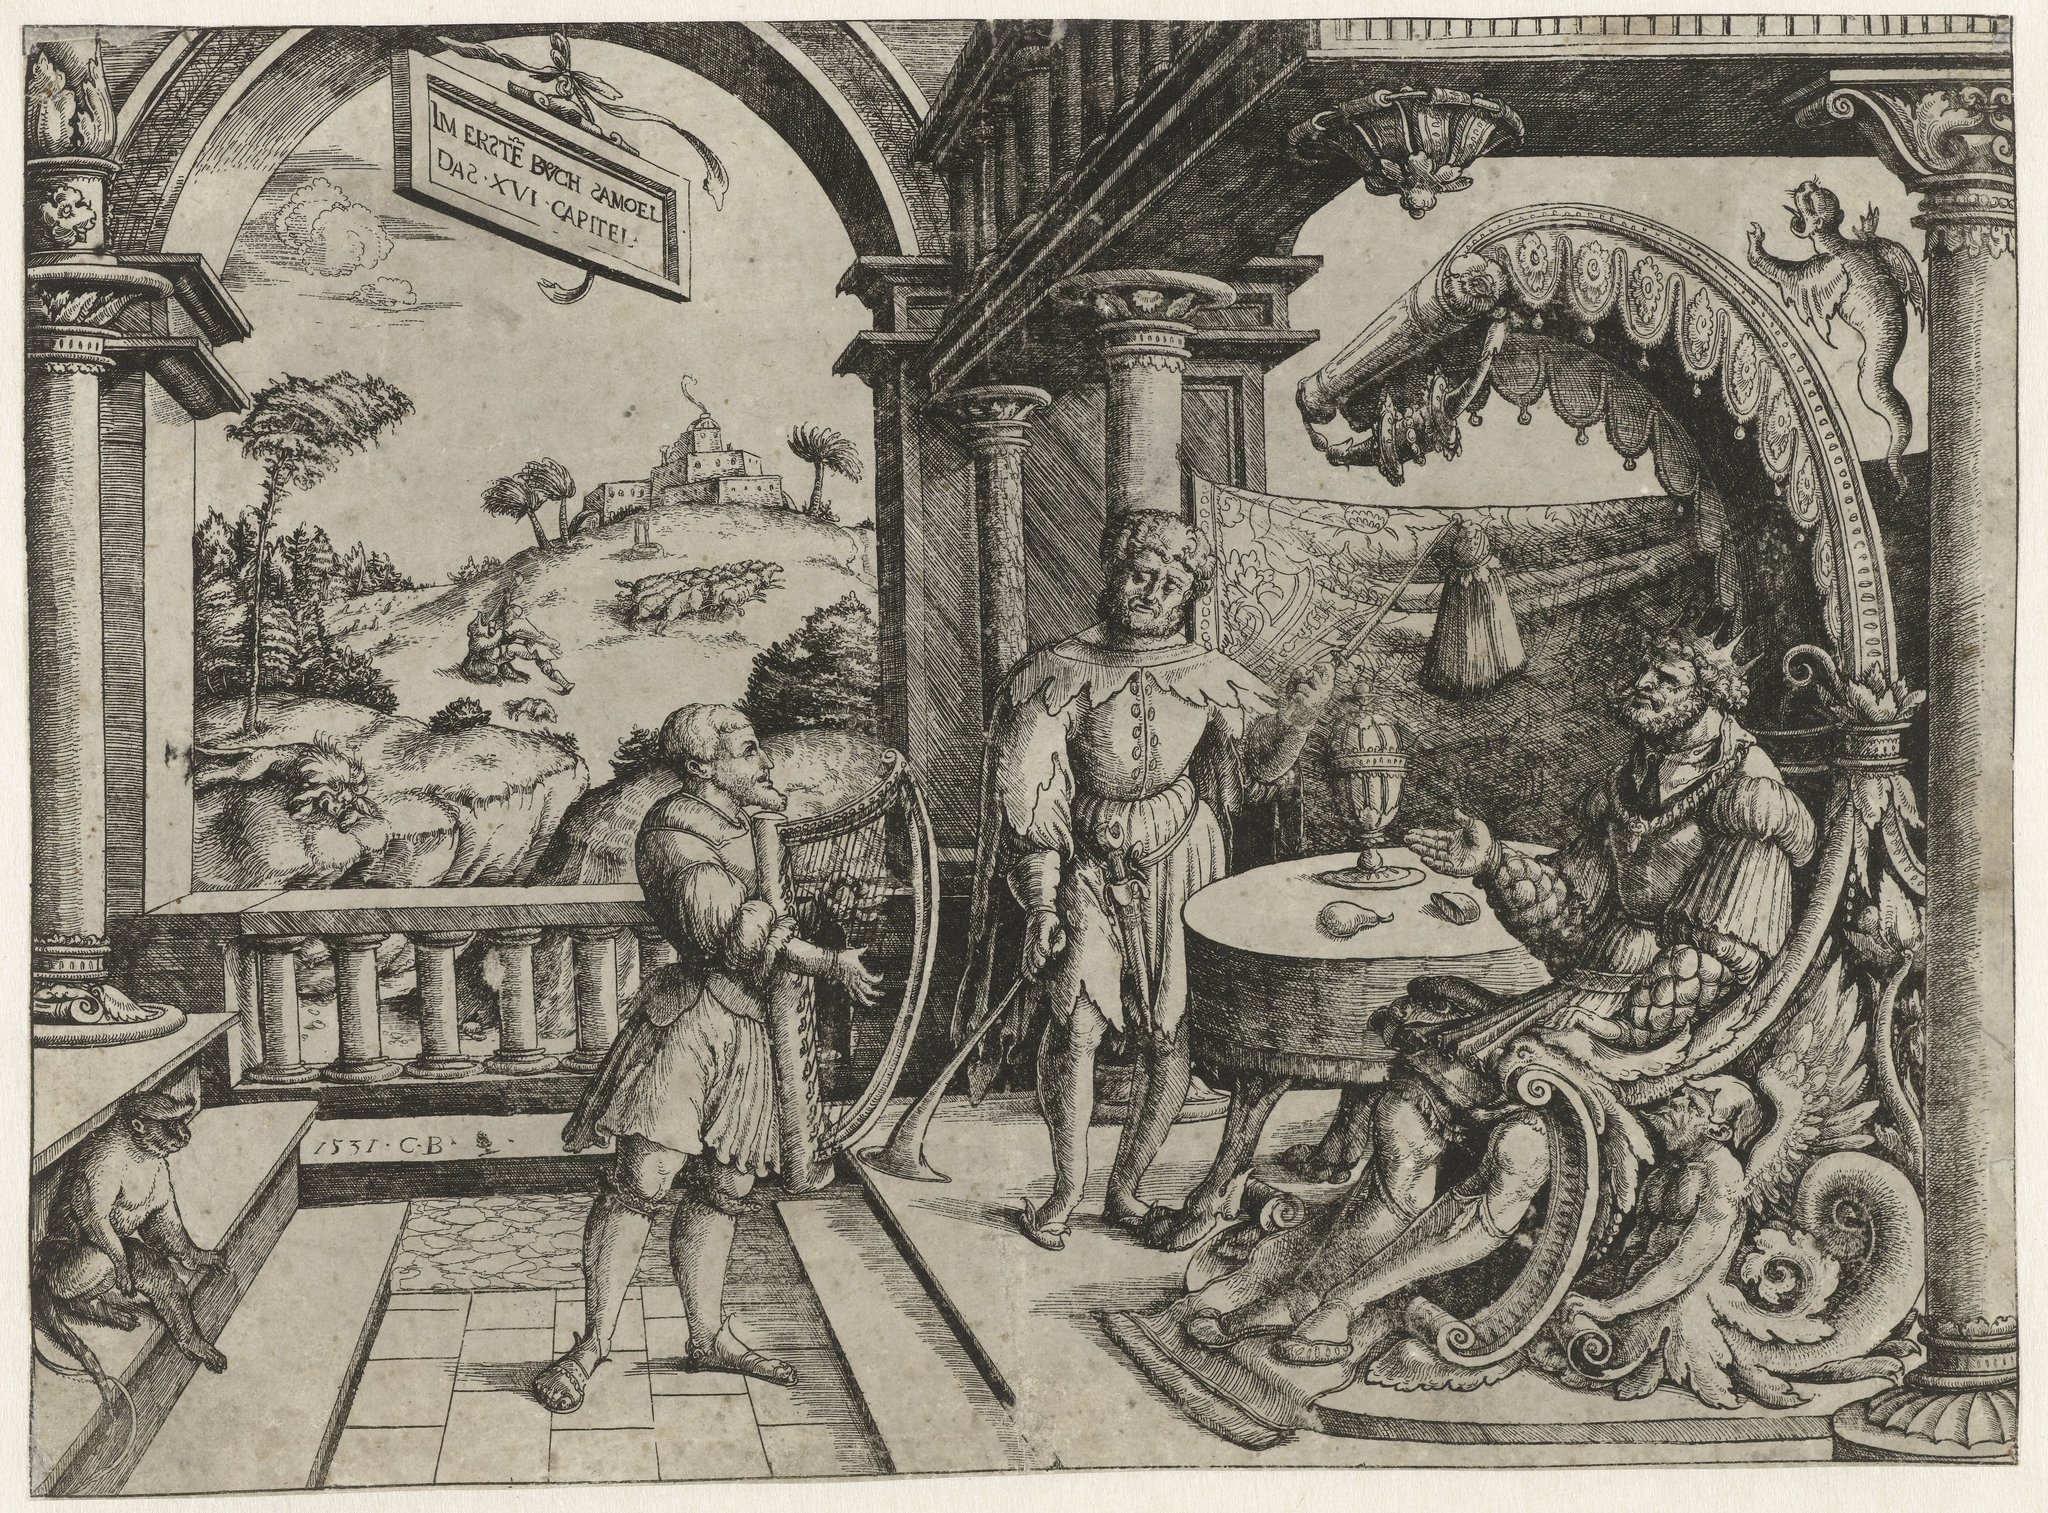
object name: print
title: David speelt harp voor Saul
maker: monogrammist cb met boom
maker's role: print maker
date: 1531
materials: paper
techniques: etching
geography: germany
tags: david as shepherd, david playing his harp before saul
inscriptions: collector's mark: Lugt 2228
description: Saul zittend op een troon in zijn paleis. Voor hem staat David die speelt op zijn harp, waardoor de kwade geest, in de vorm van een fantasie wezen, van Saul wegvliegt (1 Samuel 16:23). In het landschap op de achtergrond redt David een schaap uit de muil van een beer (1 Samuel 17:34).